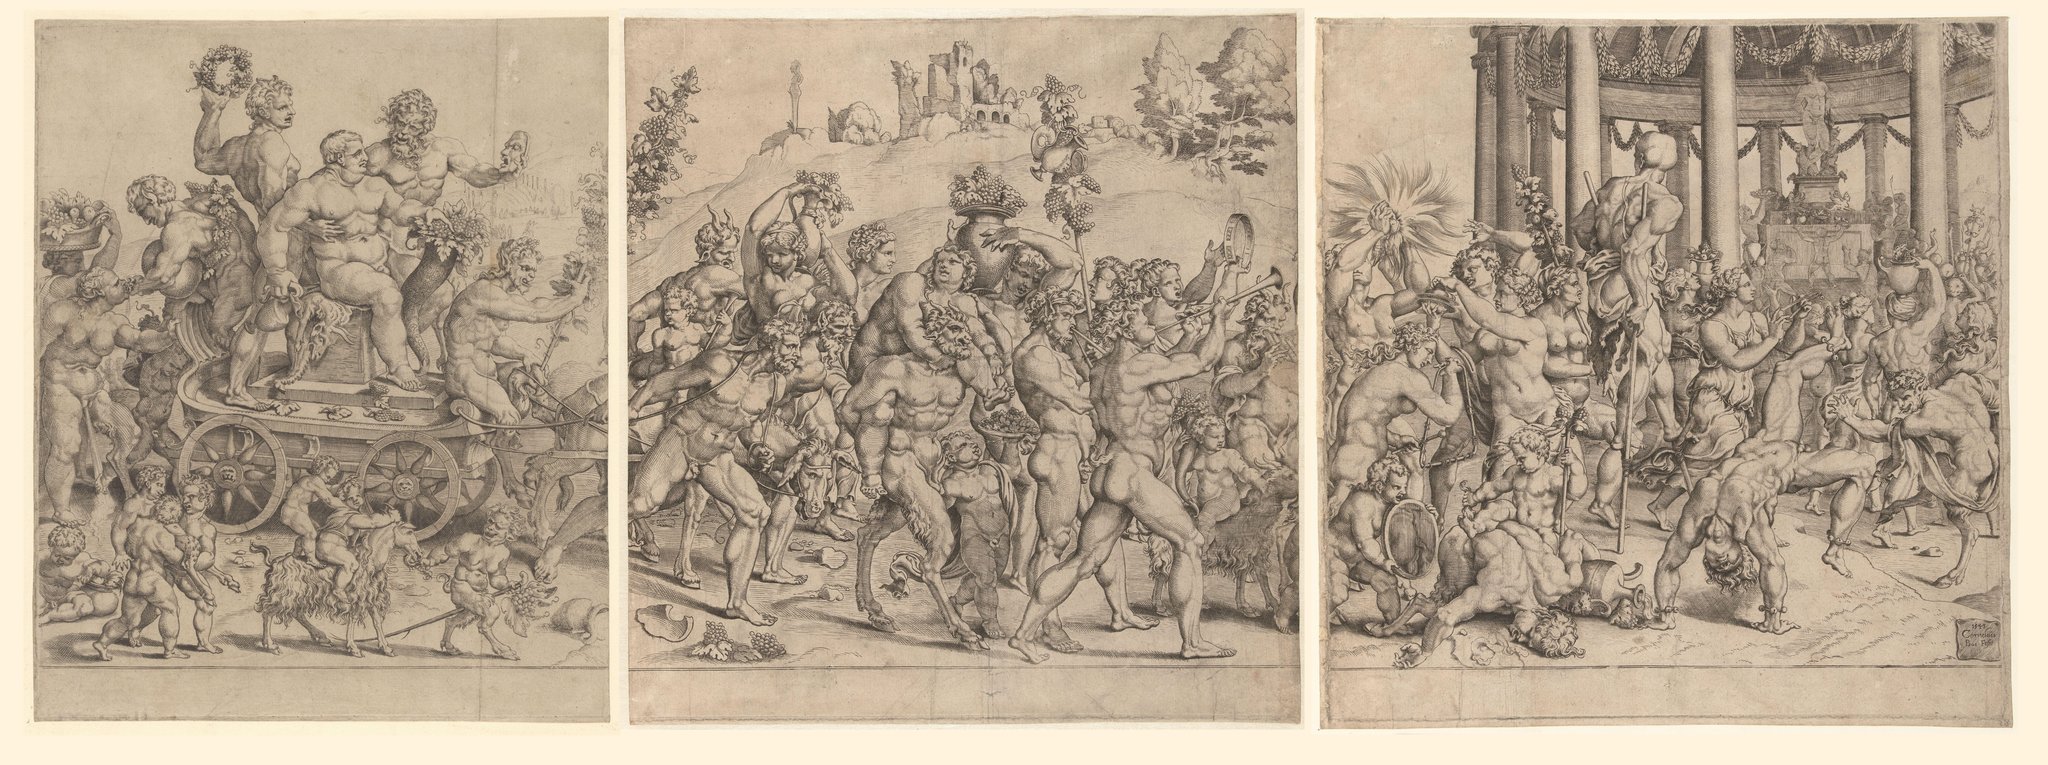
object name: print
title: Triomf van Bacchus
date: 1543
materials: paper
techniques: engraving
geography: antwerp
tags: triumph of bacchus; 'carro di bacco' (ripa)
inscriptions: collector's mark: Lugt 2228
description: Prent bestaande uit drie platen. Optocht ter ere van de God Bacchus. Op een triomfwagen zit Bacchus. In de stoet die met de wagen naar een tempel loopt zijn saters putti en anderen uitgelaten aan het feesten en dansen. Sommigen spelen op fluit of tamboerijn, anderen dragen stokken of kruiken met druiventrossen en wijnranken met zich mee.